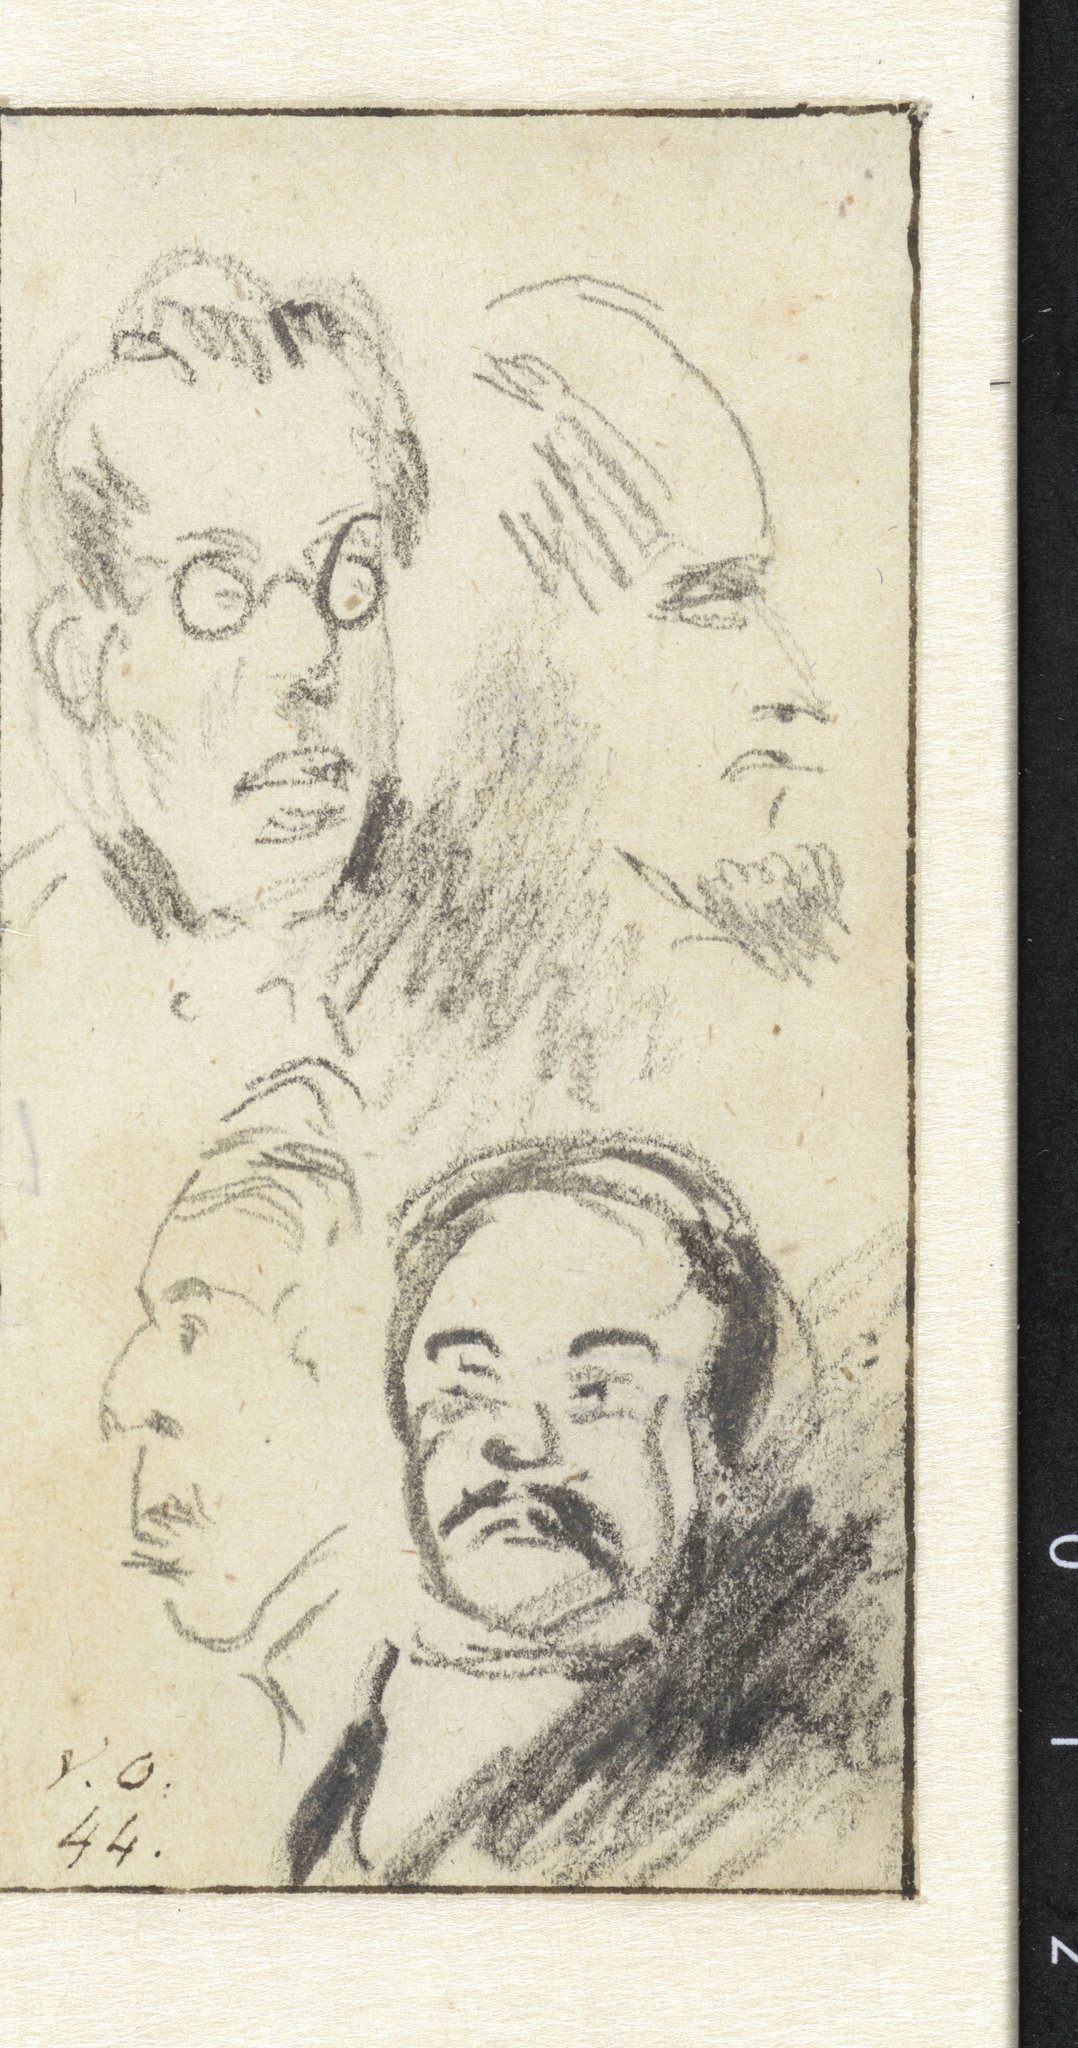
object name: drawing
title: Studies van vier mannenhoofden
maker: georgius jacobus johannes van os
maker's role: draughtsman, painter, print maker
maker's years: 1782-1861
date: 1844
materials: paper, pencil